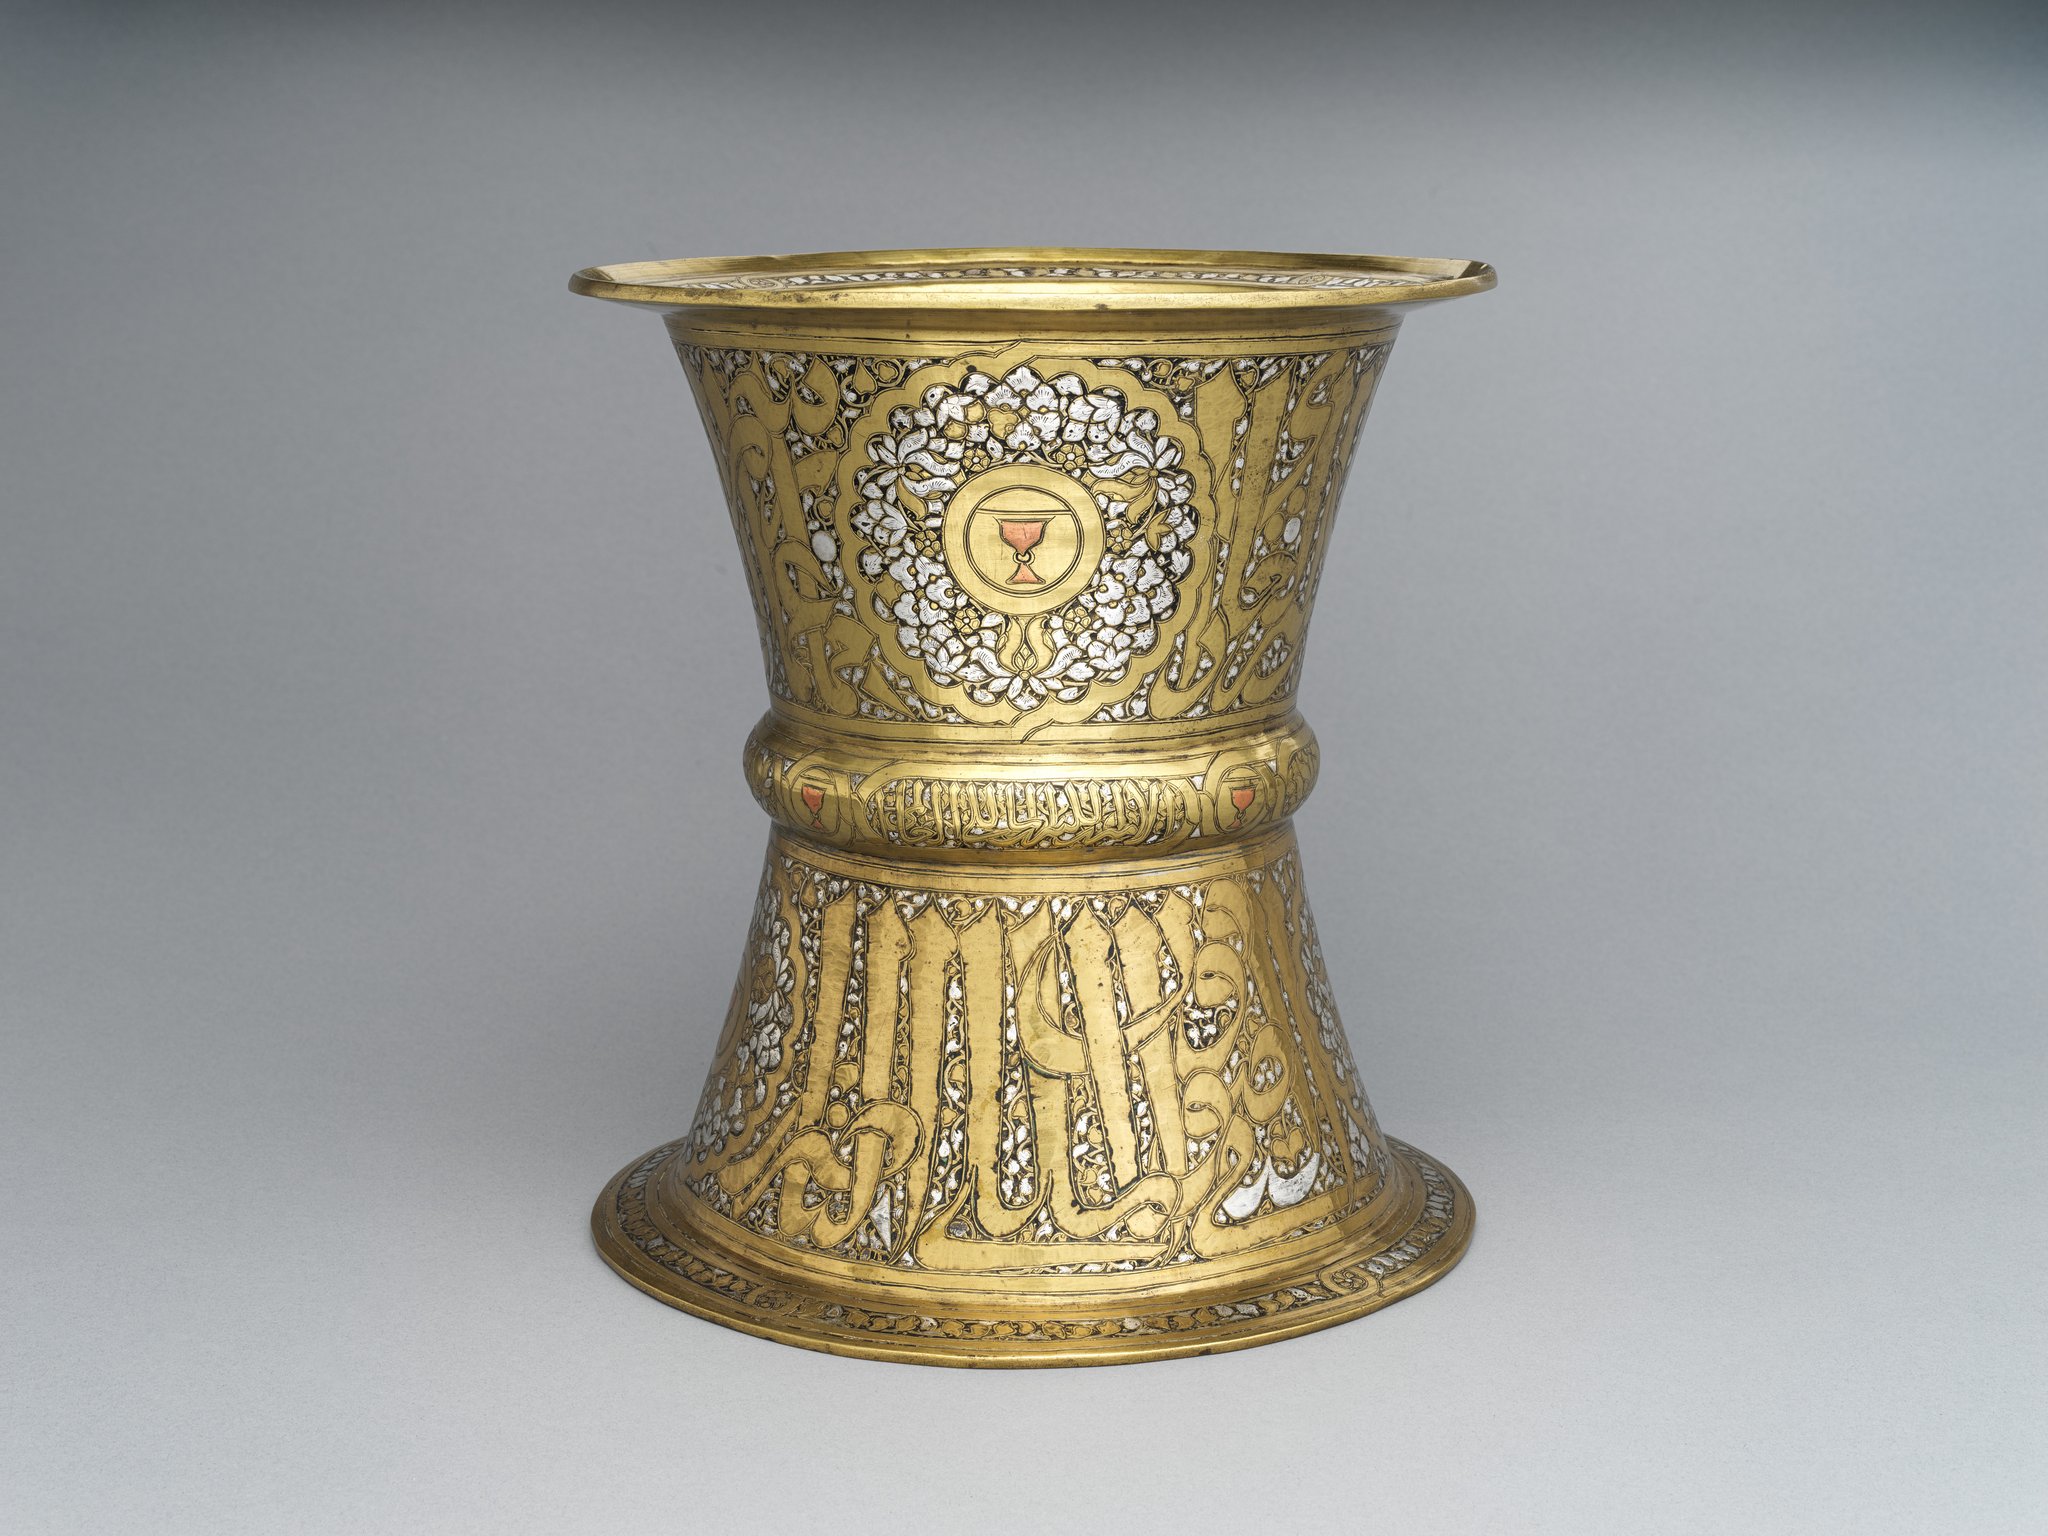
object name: stand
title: Tray Stand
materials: brass, copper, silver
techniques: chasing, hammering, inlay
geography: egypt or syria